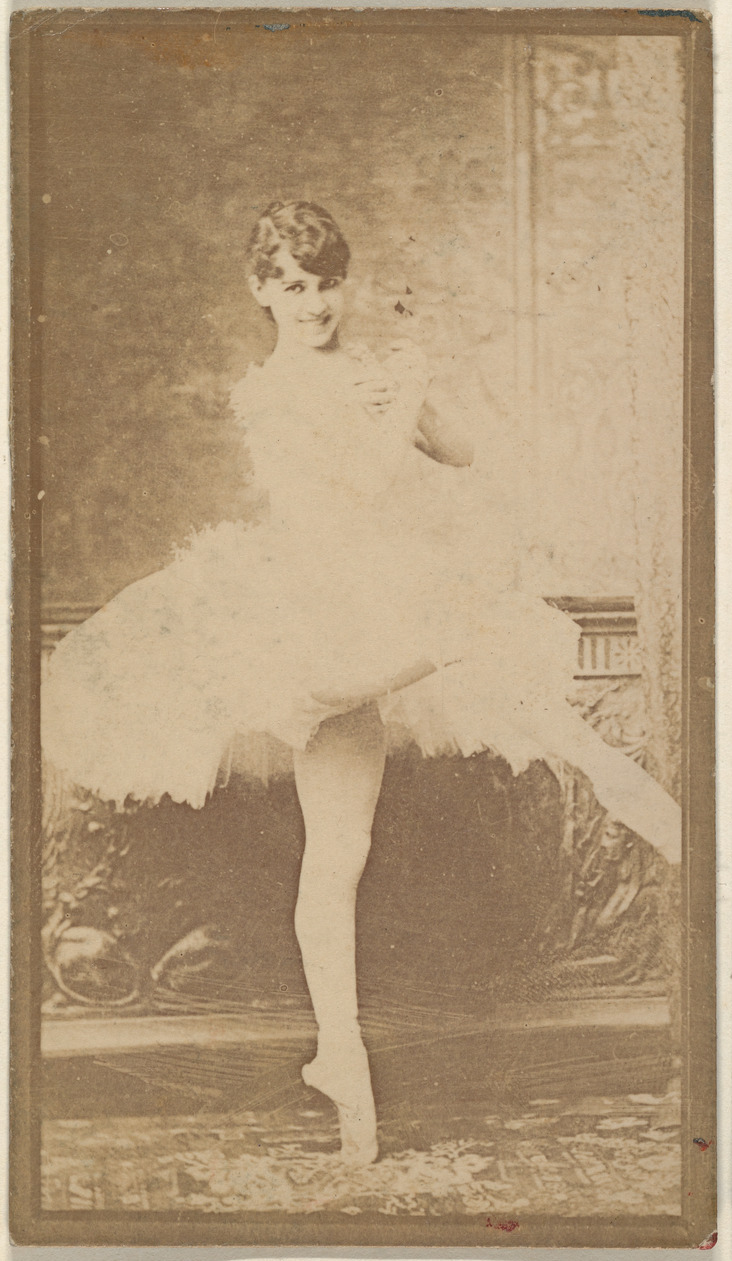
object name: photograph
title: Ballerina, from the Actresses series (N668)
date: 1888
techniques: albumen silver print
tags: portraits,women,actresses